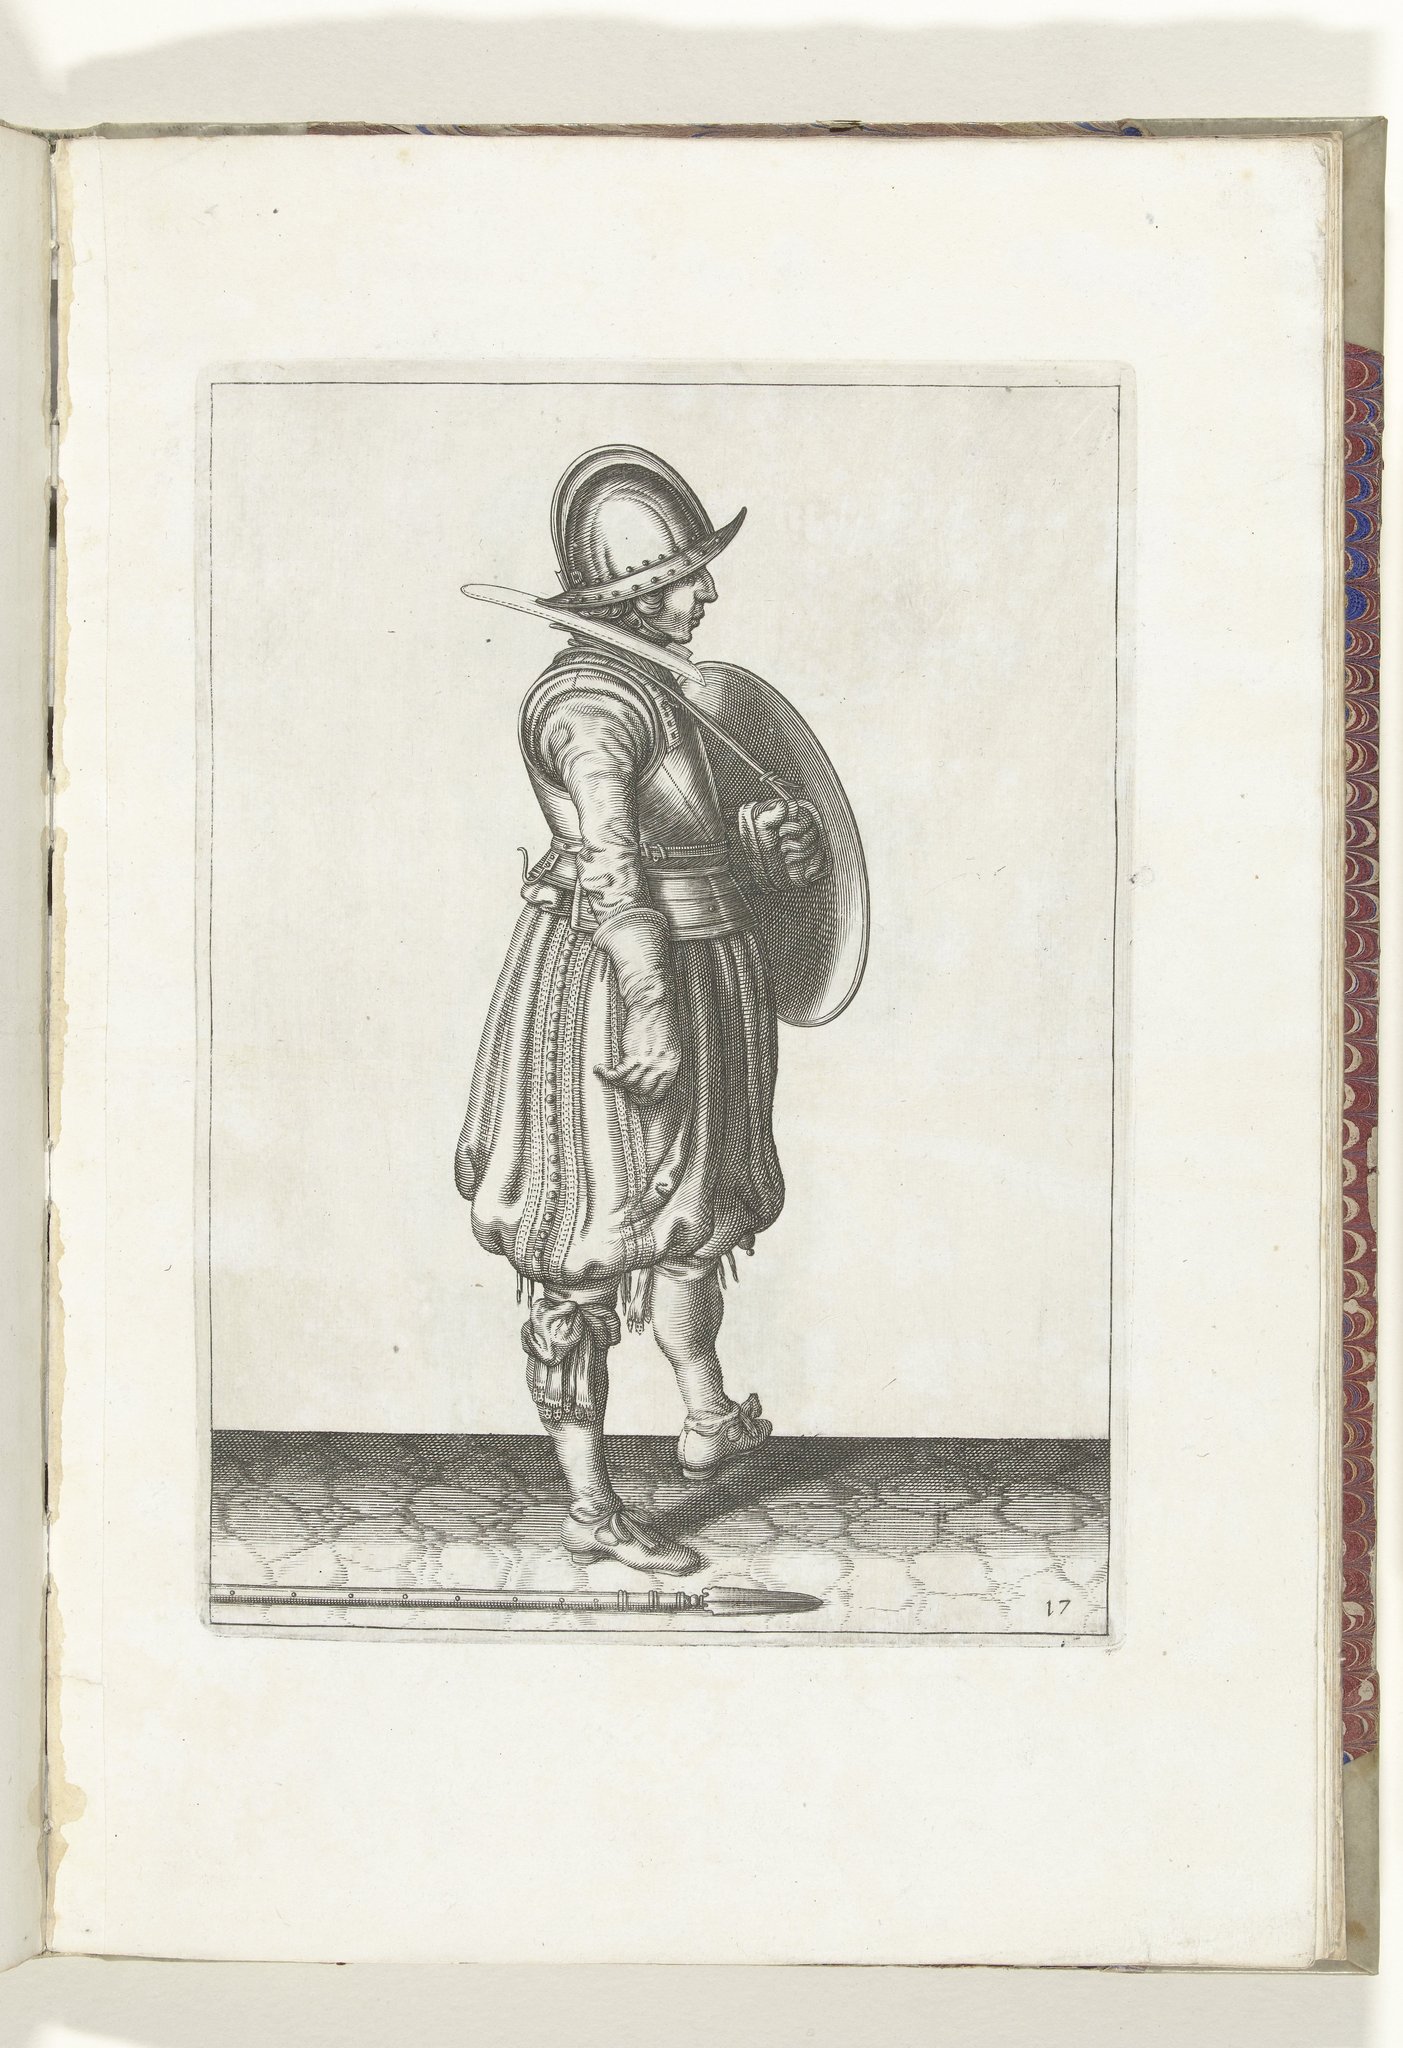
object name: print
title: De exercitie met schild en spies: de soldaat met het schild gereed en de spies naast zijn rechtervoet op de grond (nr. 17), 1618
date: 1616-1618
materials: paper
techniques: engraving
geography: northern netherlands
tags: the hague, maurice (prince of orange), handling of weapons ~ military training, weapons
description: Illustratie in: Adam van Breen, De Nassausche Wapen-Handelinge, van Schilt, Spies, Rappier ende Targe : beyde figuerlick afgebeelt, ende gestelt na de nieu ordening [van] ... Maurits van Nassau, 's-Gravenhage, [Aert Meuris] 1618, plaat nr. 17. In het exemplaar in de collectie van de Rijksmuseum Research Library (326 F 22).